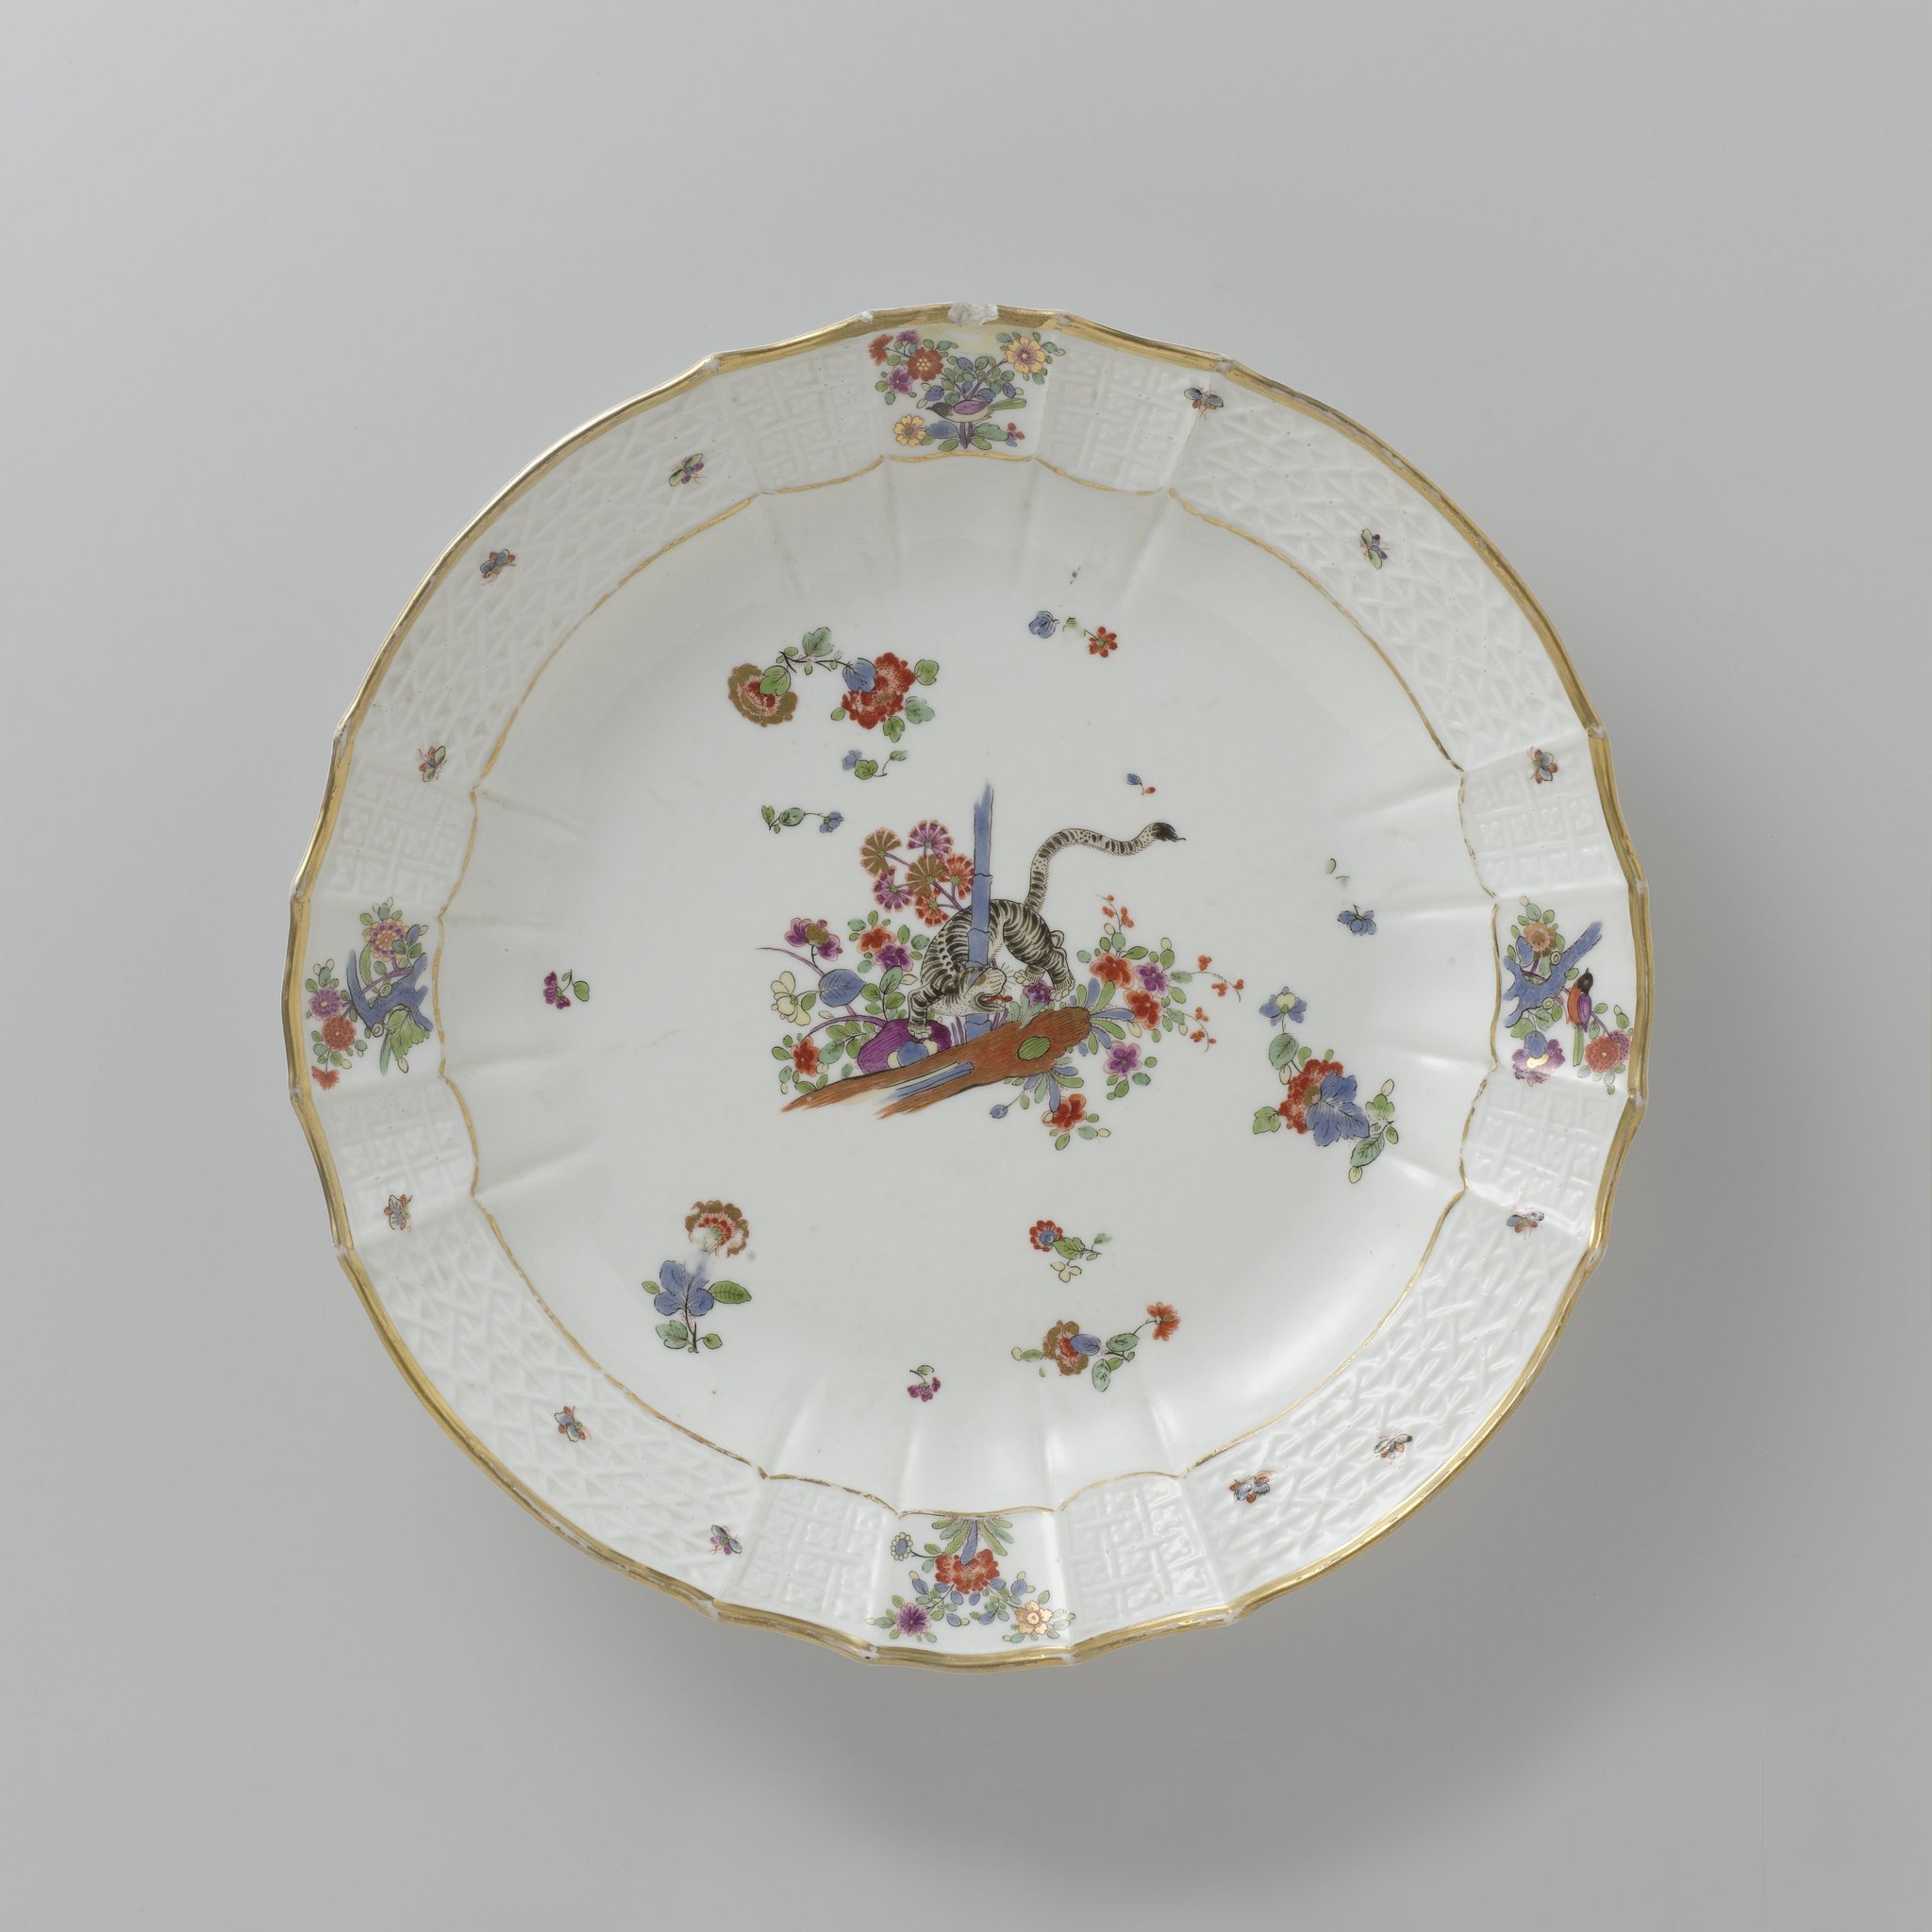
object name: eating drinking utensil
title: Schotel, veelkleurig beschilderd met een Kakiemon-decor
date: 1740-1745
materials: porcelain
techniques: painted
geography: meissen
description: Ronde schotel van beschilderd porselein. De schotel heeft een geribde en geschulpte rand. De schotel is beschilderd met een tijger om een bamboestengel, gestrooide Indianische Blumen, vlinders en takken met vogels. De rand is versierd met het 'Altbrandenstein'-patroon. De schotel is gemerkt.